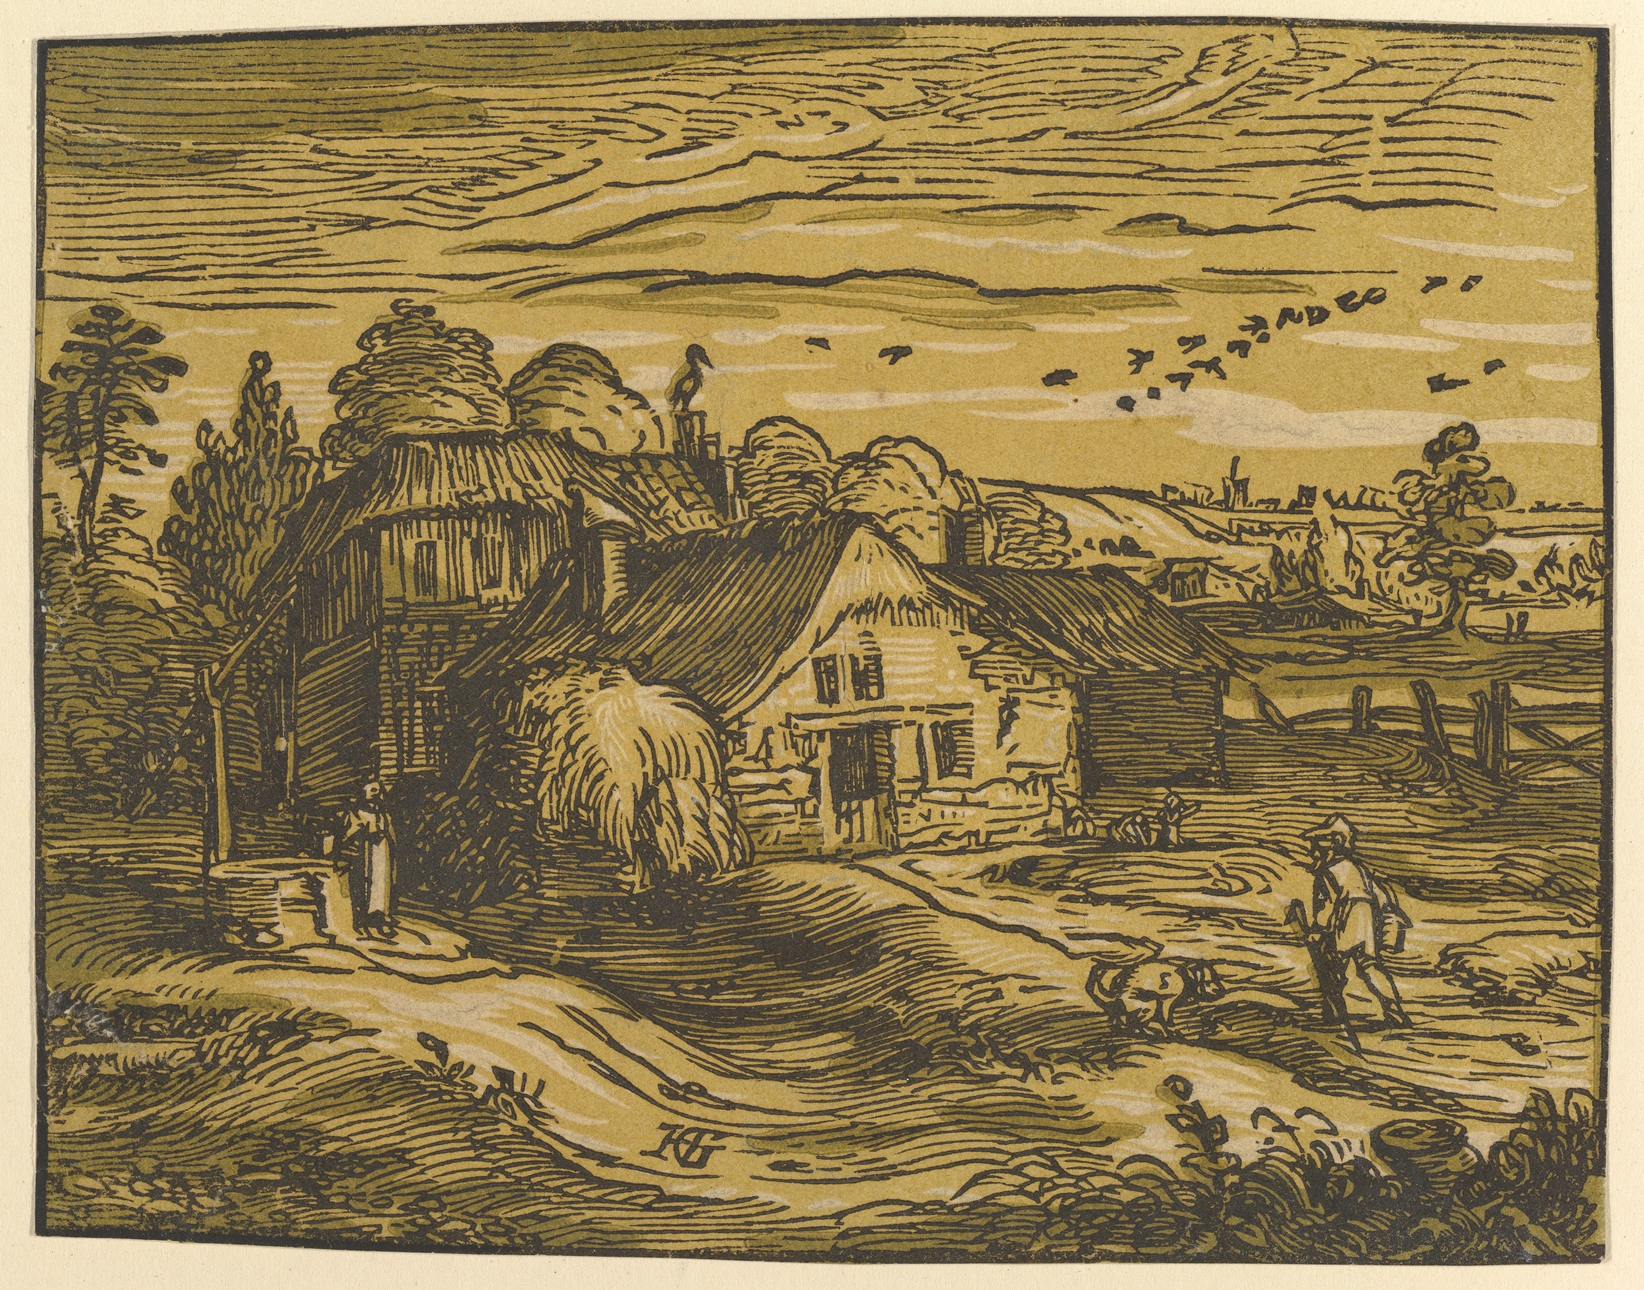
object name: print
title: Landscape with Cottage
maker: hendrick goltzius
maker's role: artist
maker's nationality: netherlandish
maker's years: 1558-1617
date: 1597-1598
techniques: woodcut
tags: birds,houses,men,women,dogs,landscapes,trees